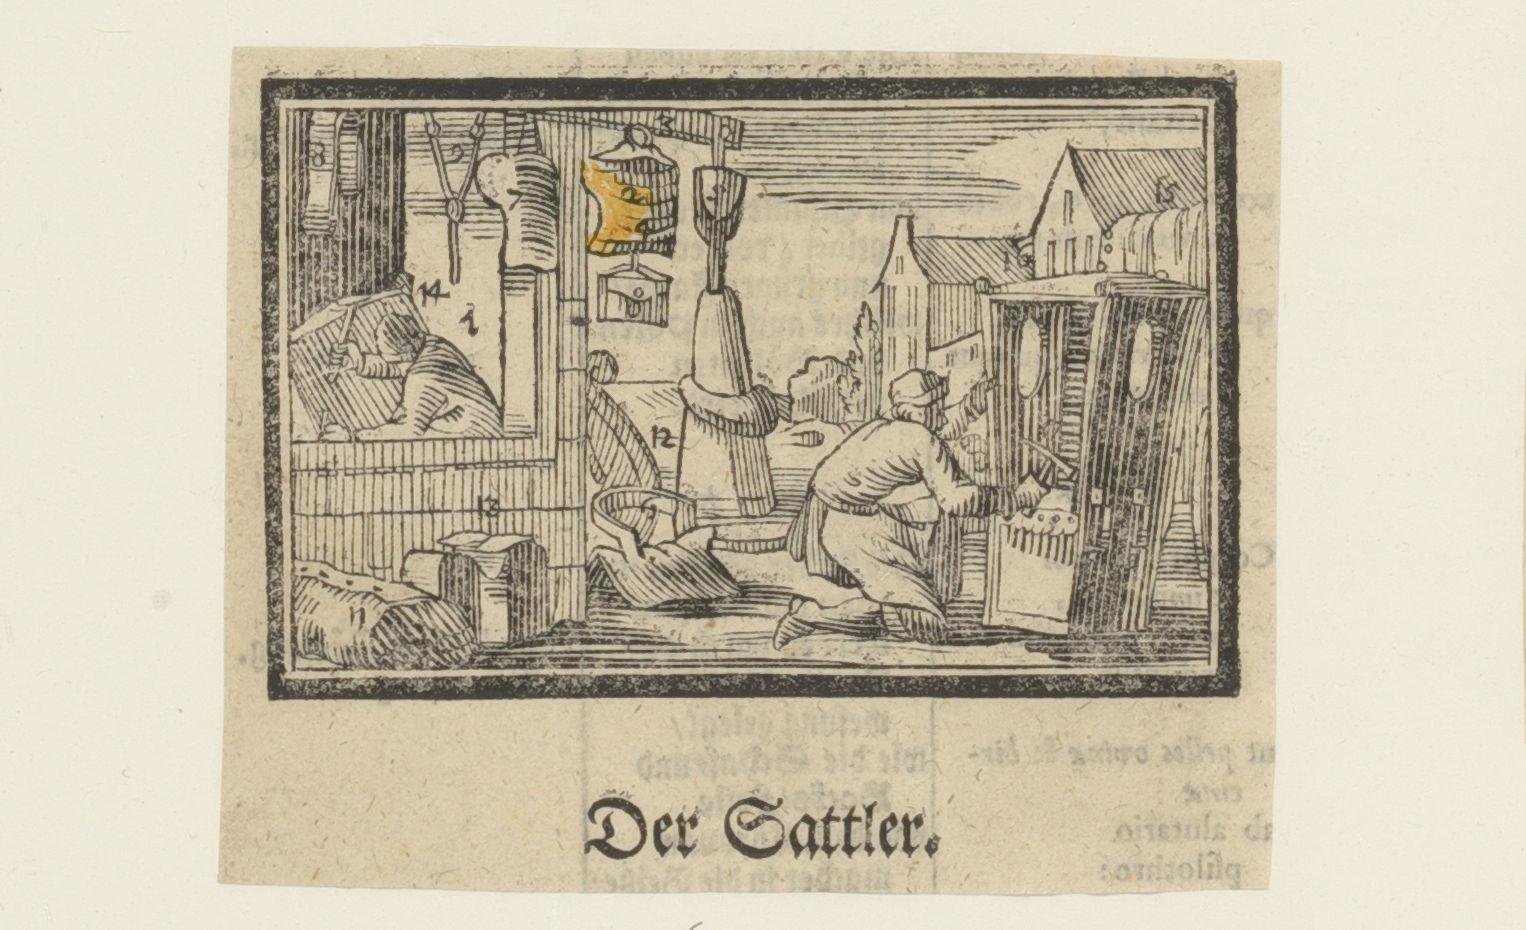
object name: print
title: Zadelmaker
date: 1719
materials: paper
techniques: letterpress printing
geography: nuremberg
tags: saddle and bridle (saddlery), handicrafts, craftsman at work, gloves, mittens, etc., leather industry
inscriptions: stamp, collector's mark: Lugt 1641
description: Prent uit: Comenius, Johannes Amosius. Orbis sensualium picti pars prima (...). Neurenberg: Martin Endter, 1719, dl. 2, p. 212. Prent eerder gebruikt in: Comenius, Johannes Amosius. Orbis Sensualium Picti denuo aucti Pars Secunda (...). Neurenberg: Martin Endter, 1730, dl. 2.